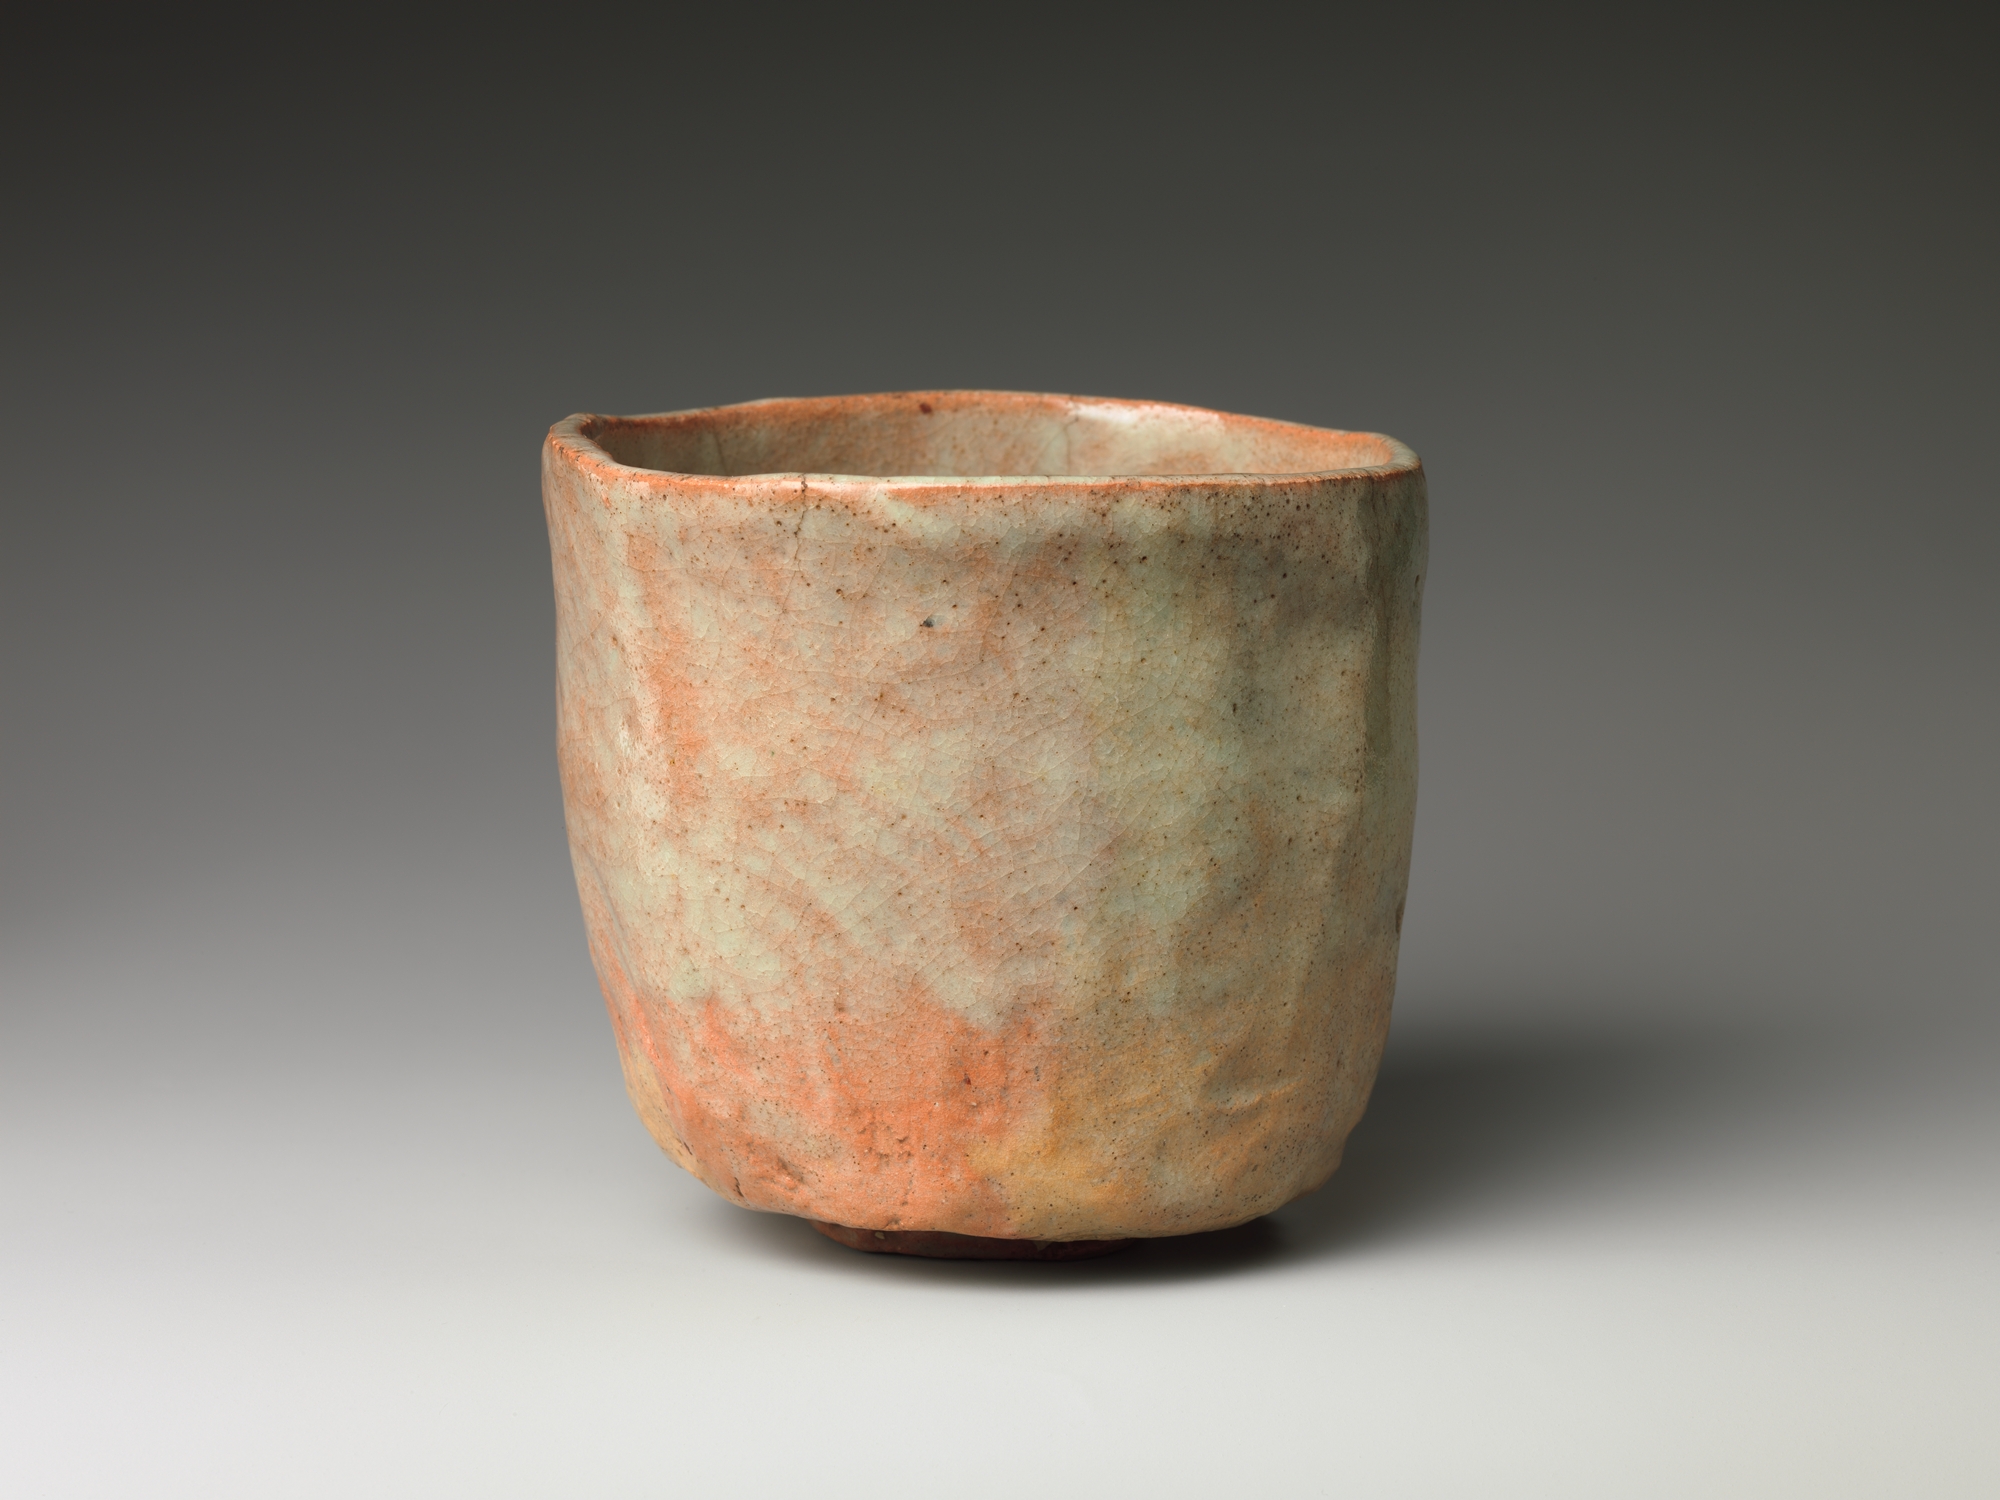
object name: teabowl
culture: japanese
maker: sonyu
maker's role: artist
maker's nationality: japanese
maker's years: 1625-1725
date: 1710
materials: clay, glaze